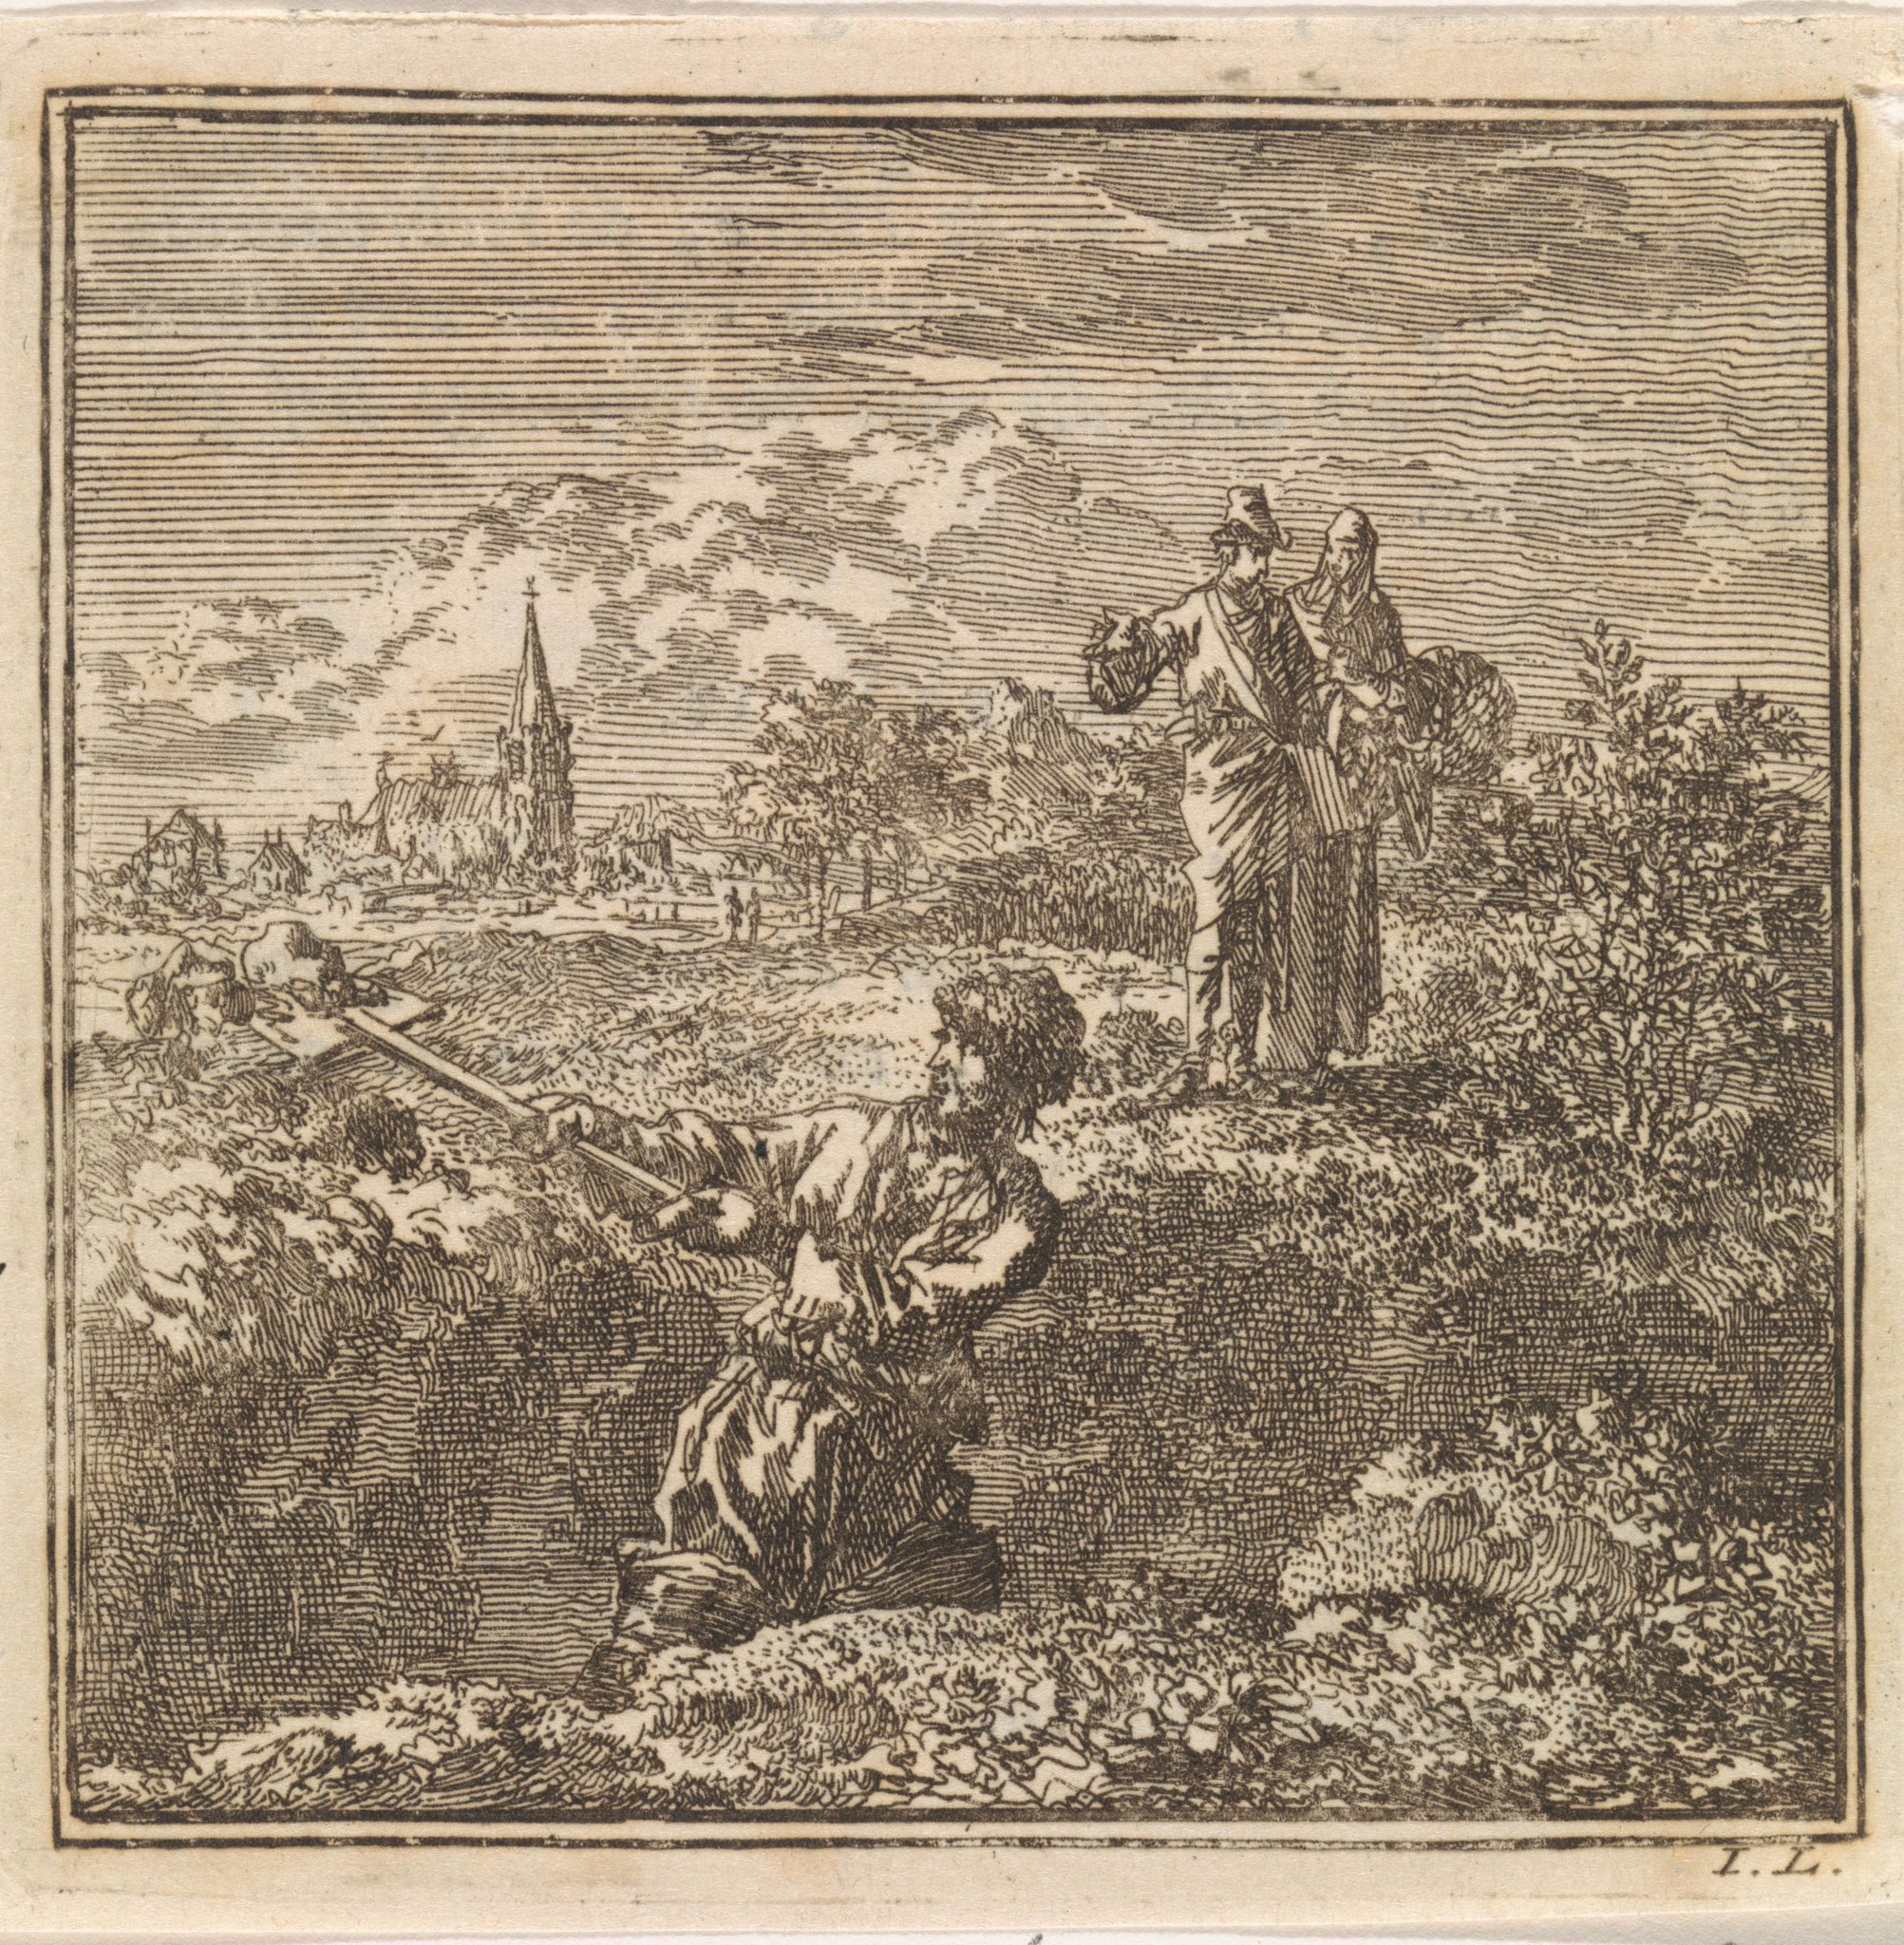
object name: book illustration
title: Man graaft een diepe kuil opzoek naar mosterdzaad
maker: jan luyken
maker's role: draughtsman, print maker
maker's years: 1649-1712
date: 1711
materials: paper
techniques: etching, letterpress printing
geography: amsterdam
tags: mustard, pit, hole, digging for or finding of treasure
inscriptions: collector's mark: Lugt 2228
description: Illustratie voor: Luyken, Jan. De Bykorf des Gemoeds. Amsterdam: Pieter Arentsz. II (wed.) en Cornelis van der Sys, 1711, p. 390.